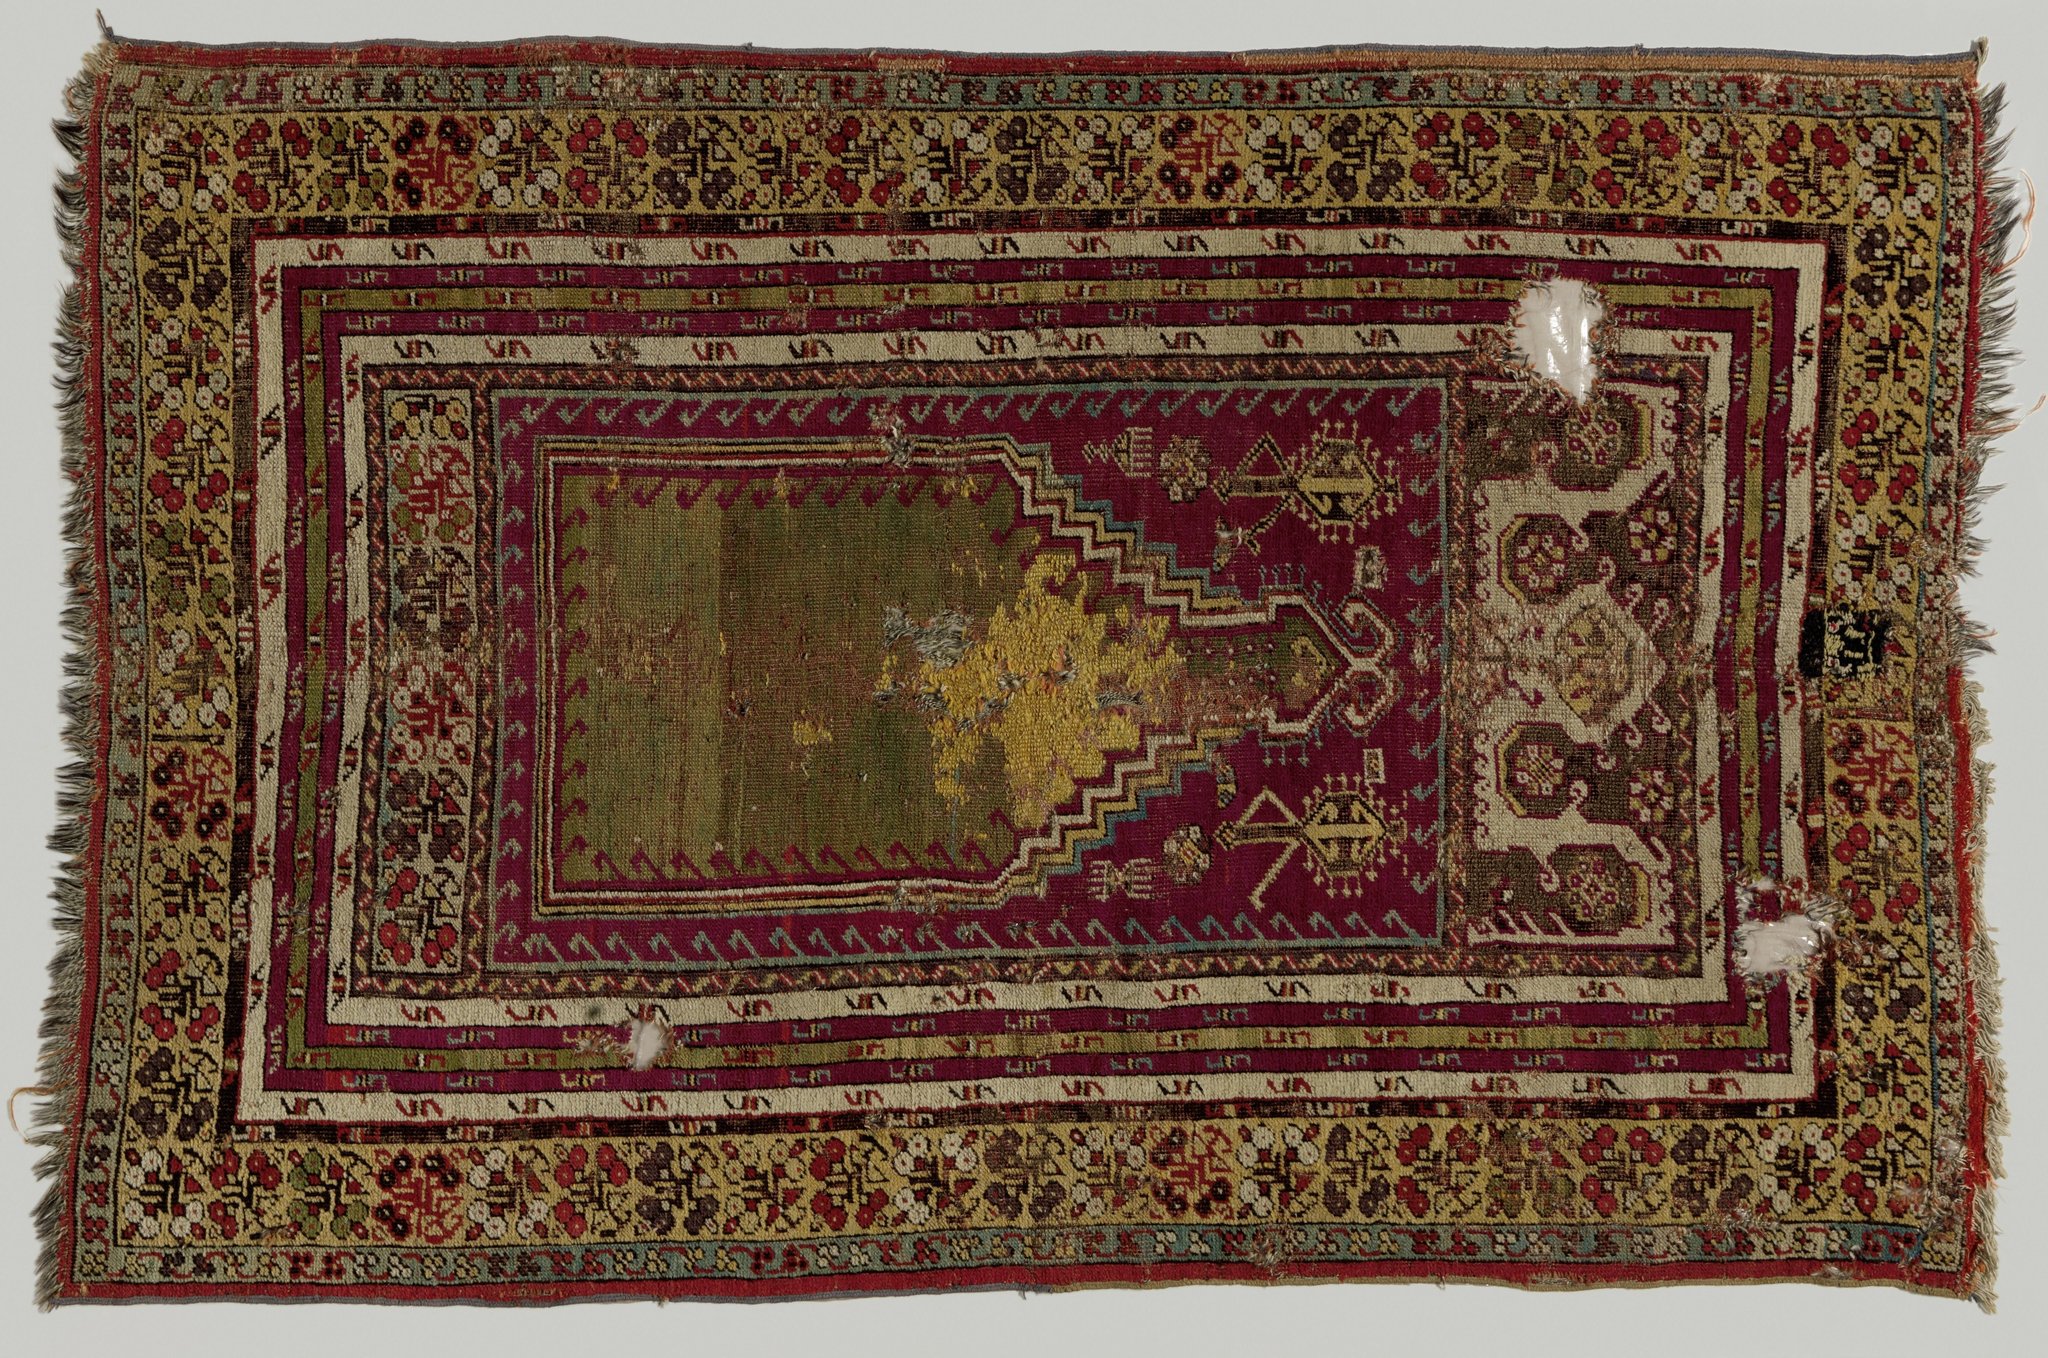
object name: prayer rug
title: Oosters tapijt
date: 1800-1900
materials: wool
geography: kirsehir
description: Oosters tapijt, bidkleed. Op het middenveld een mosgroene mihrab